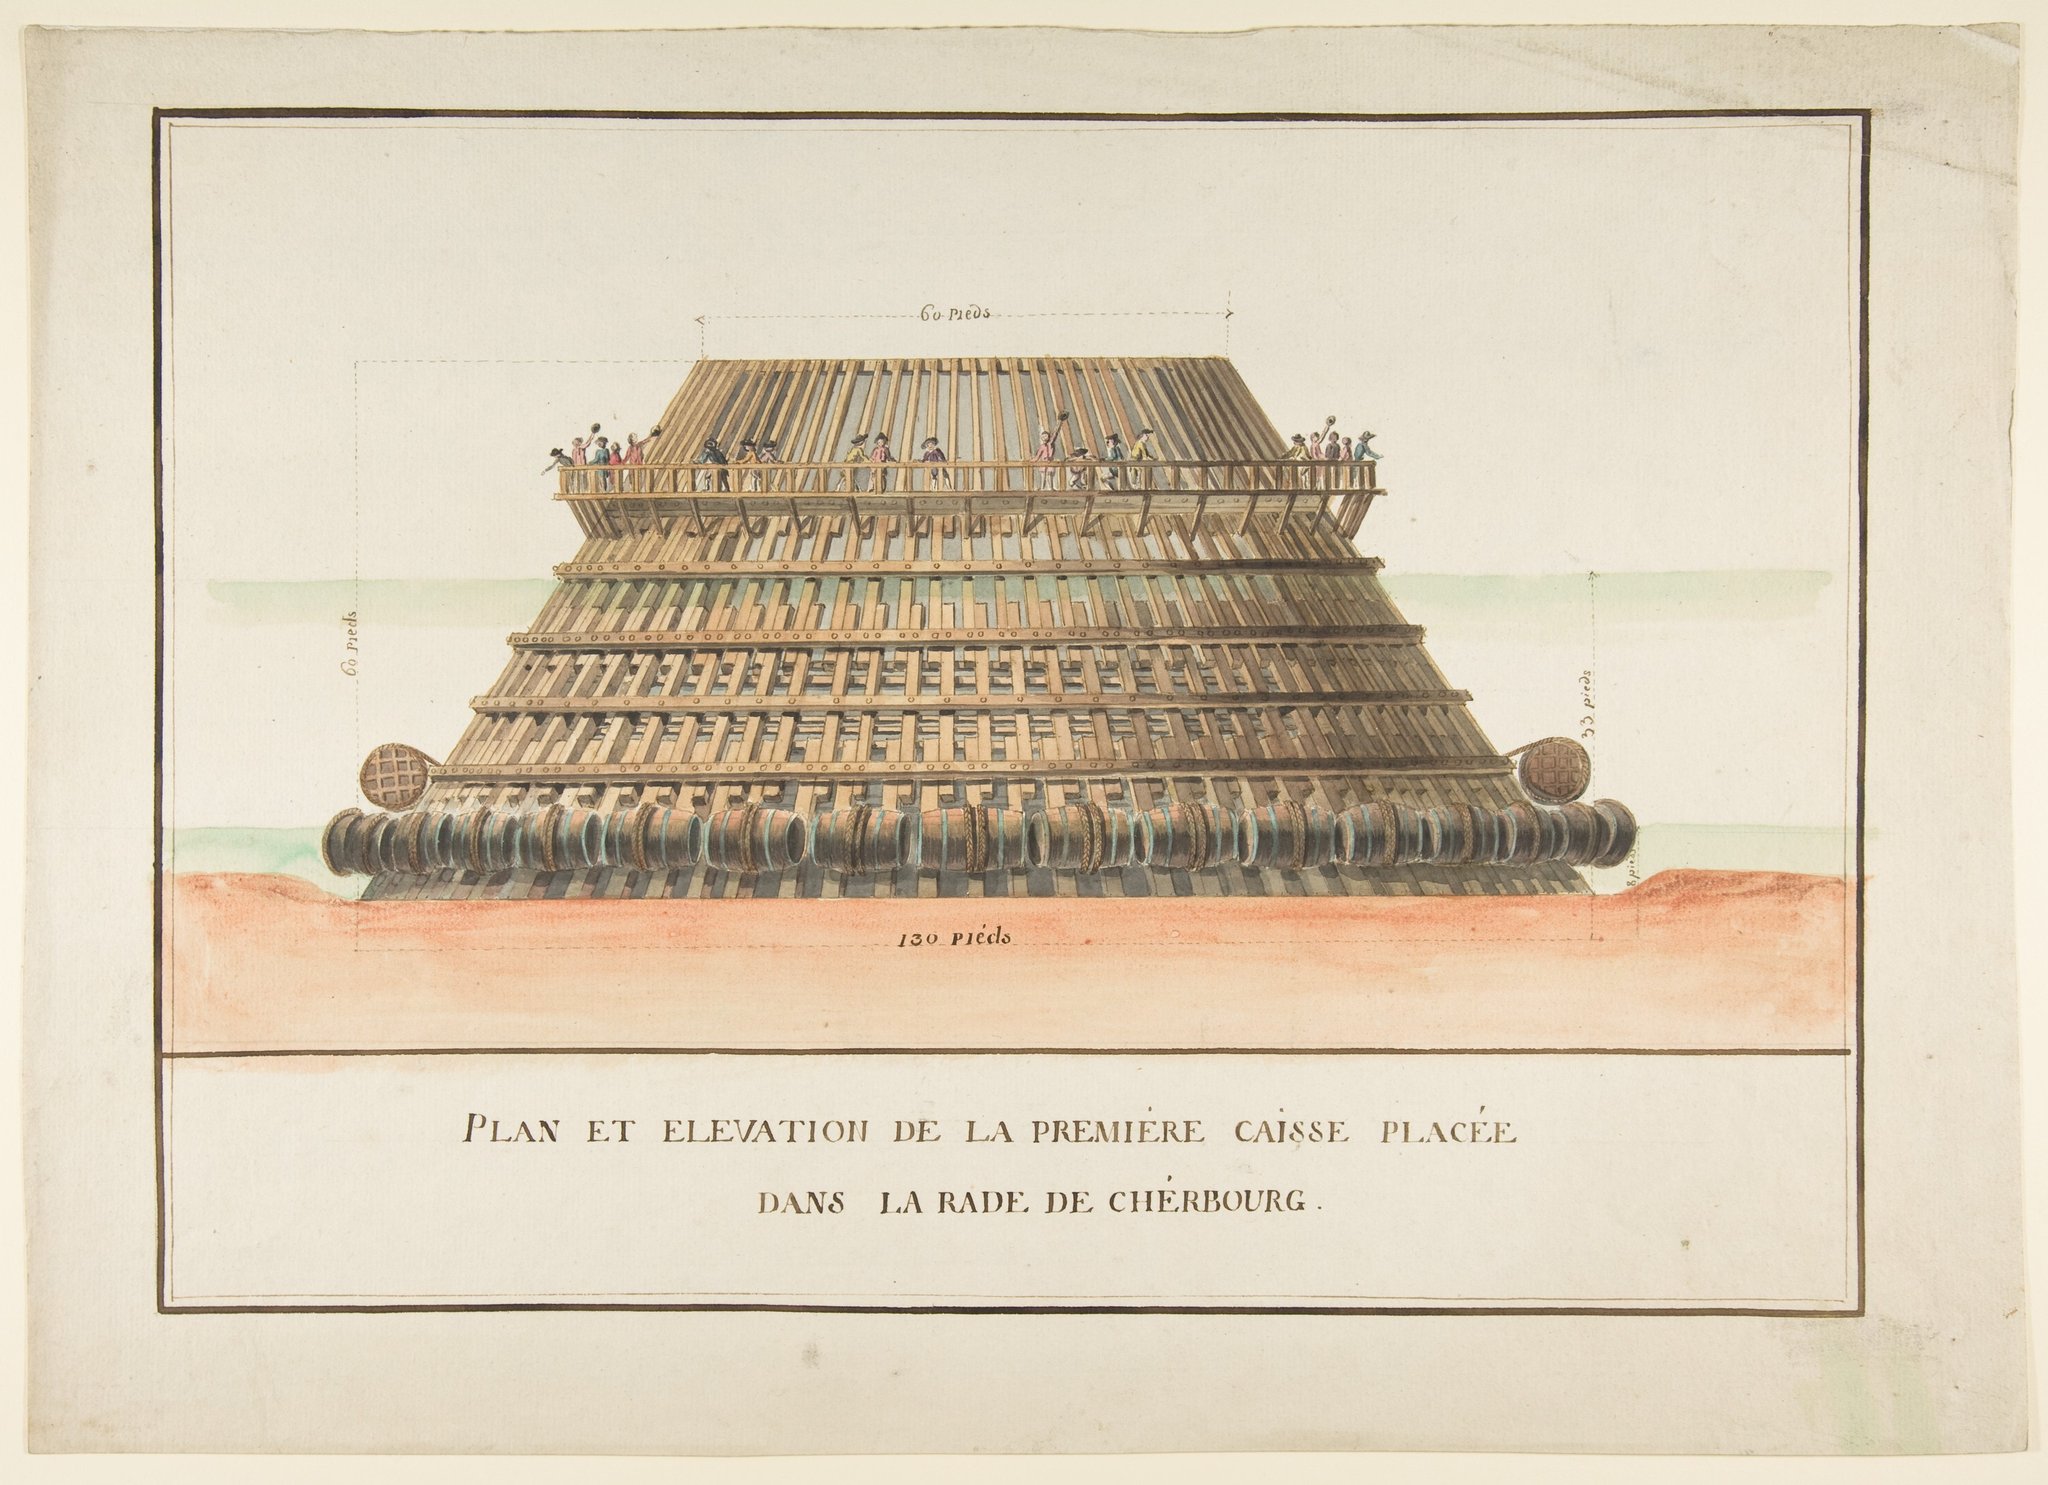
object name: drawing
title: Design for a Machine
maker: anonymous, french, 18th century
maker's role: artist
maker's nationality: french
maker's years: 1700-1800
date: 1701-1800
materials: ink, watercolor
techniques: pen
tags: machines